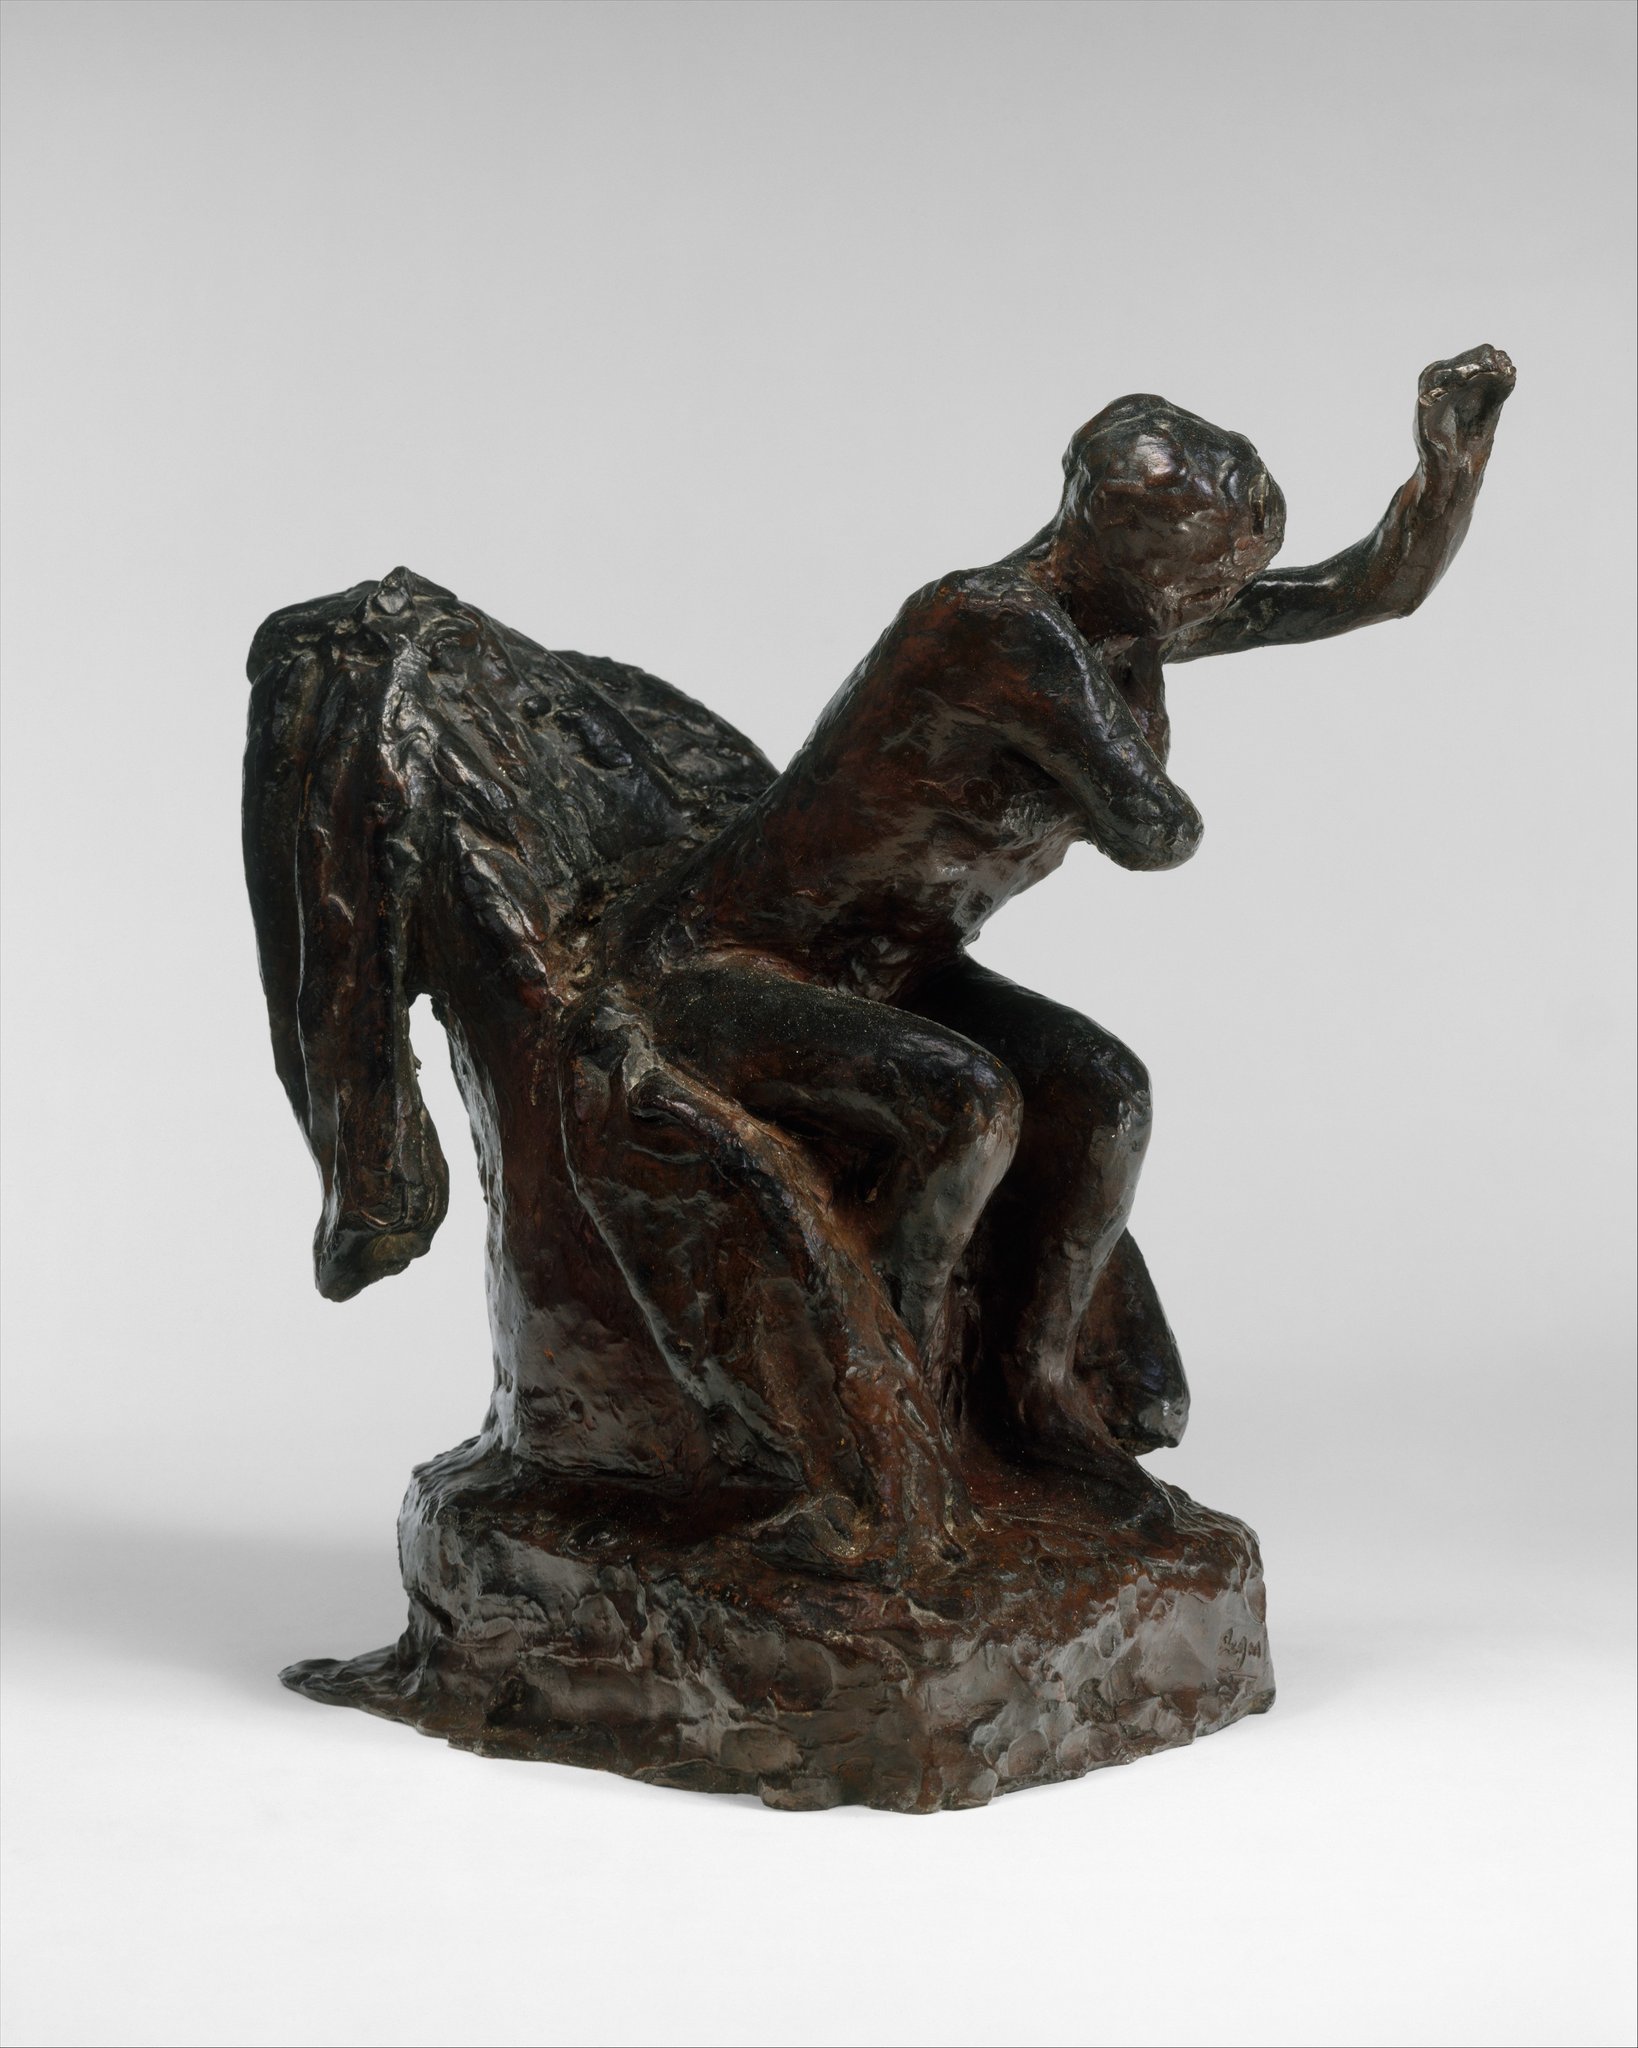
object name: statuette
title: Woman Seated in Armchair Wiping Her Left Armpit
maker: edgar degas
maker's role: artist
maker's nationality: french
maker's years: 1834-1917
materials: bronze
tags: women